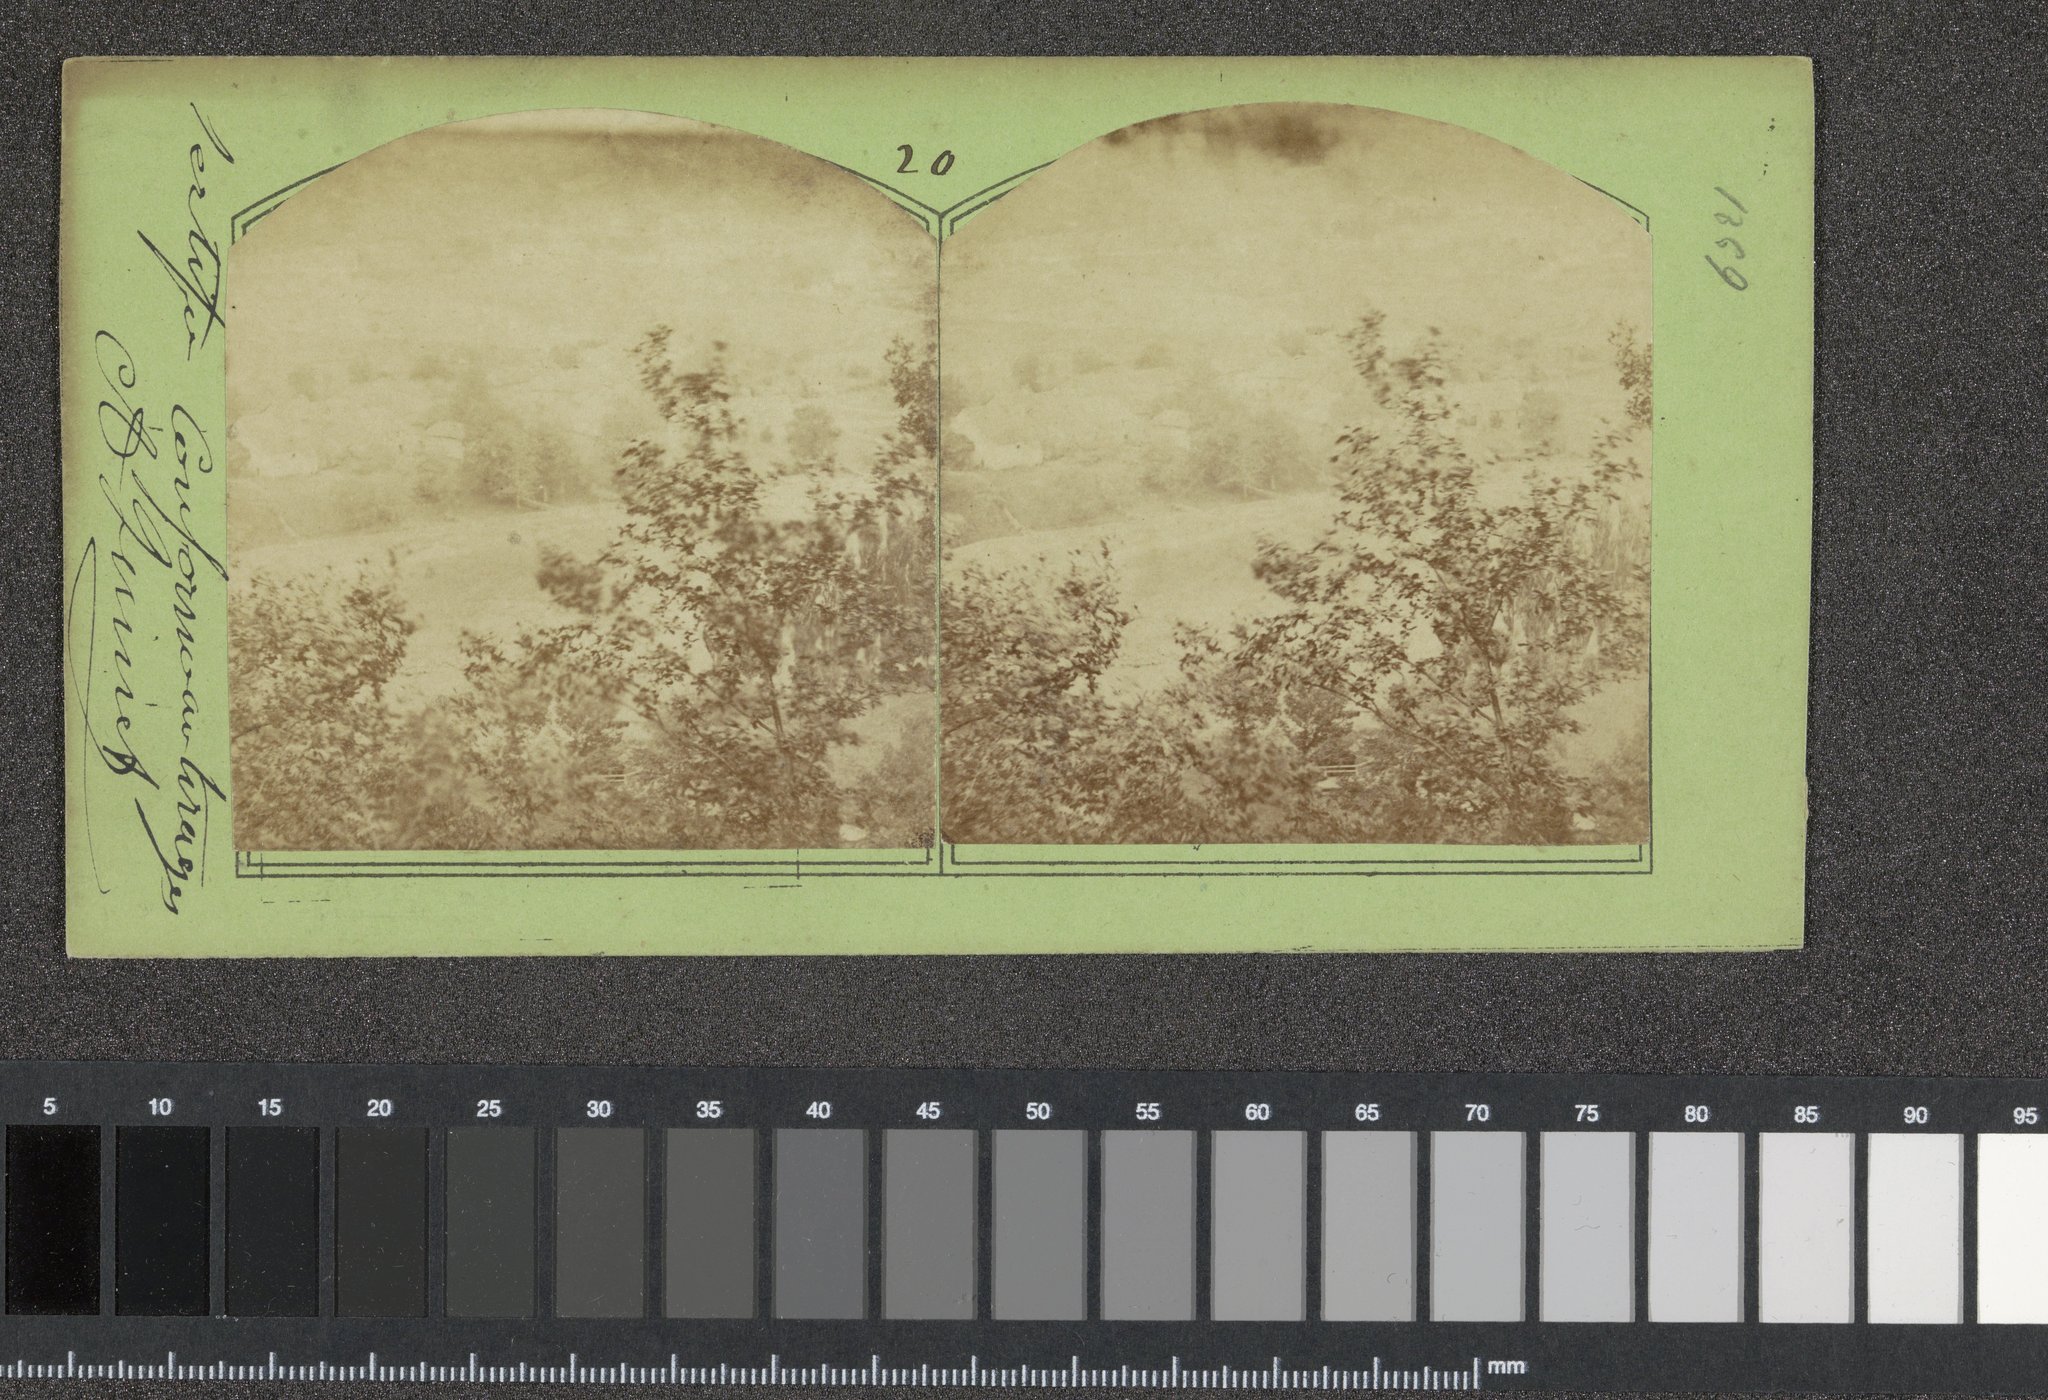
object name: stereograph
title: Bosschage met op de achtergrond bomen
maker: achille quinet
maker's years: 1831-1900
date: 1860-1880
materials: cardboard, paper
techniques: albumen print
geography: alps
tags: mountains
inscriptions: signature: ‘Sertifier conforme au tirages // A Quinet’